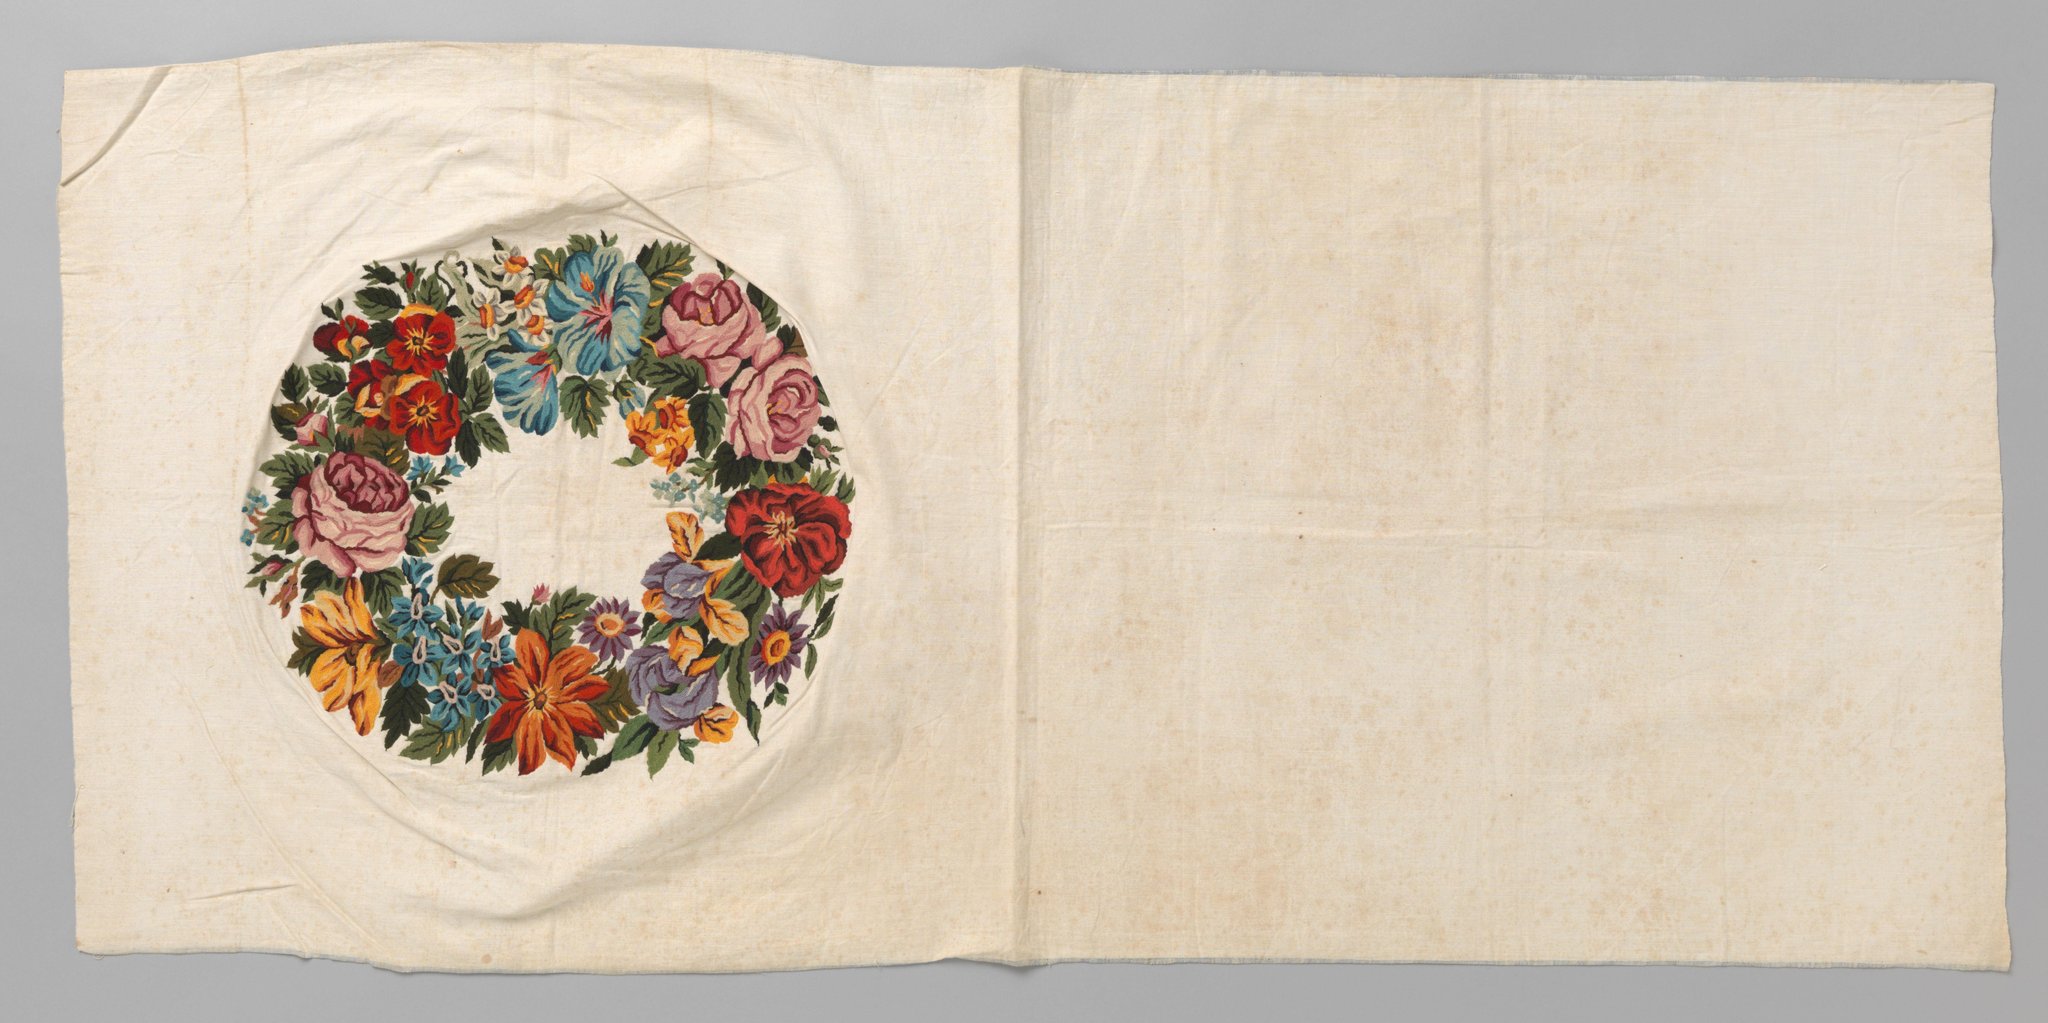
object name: bekledingsstof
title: Metrage bekledingsstof met borduurwerk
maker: Anonymous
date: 1850-1949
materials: cotton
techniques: weave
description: Metrage bekledingsstof, geborduurd met kleurige bloemenkransen in kettingsteek.